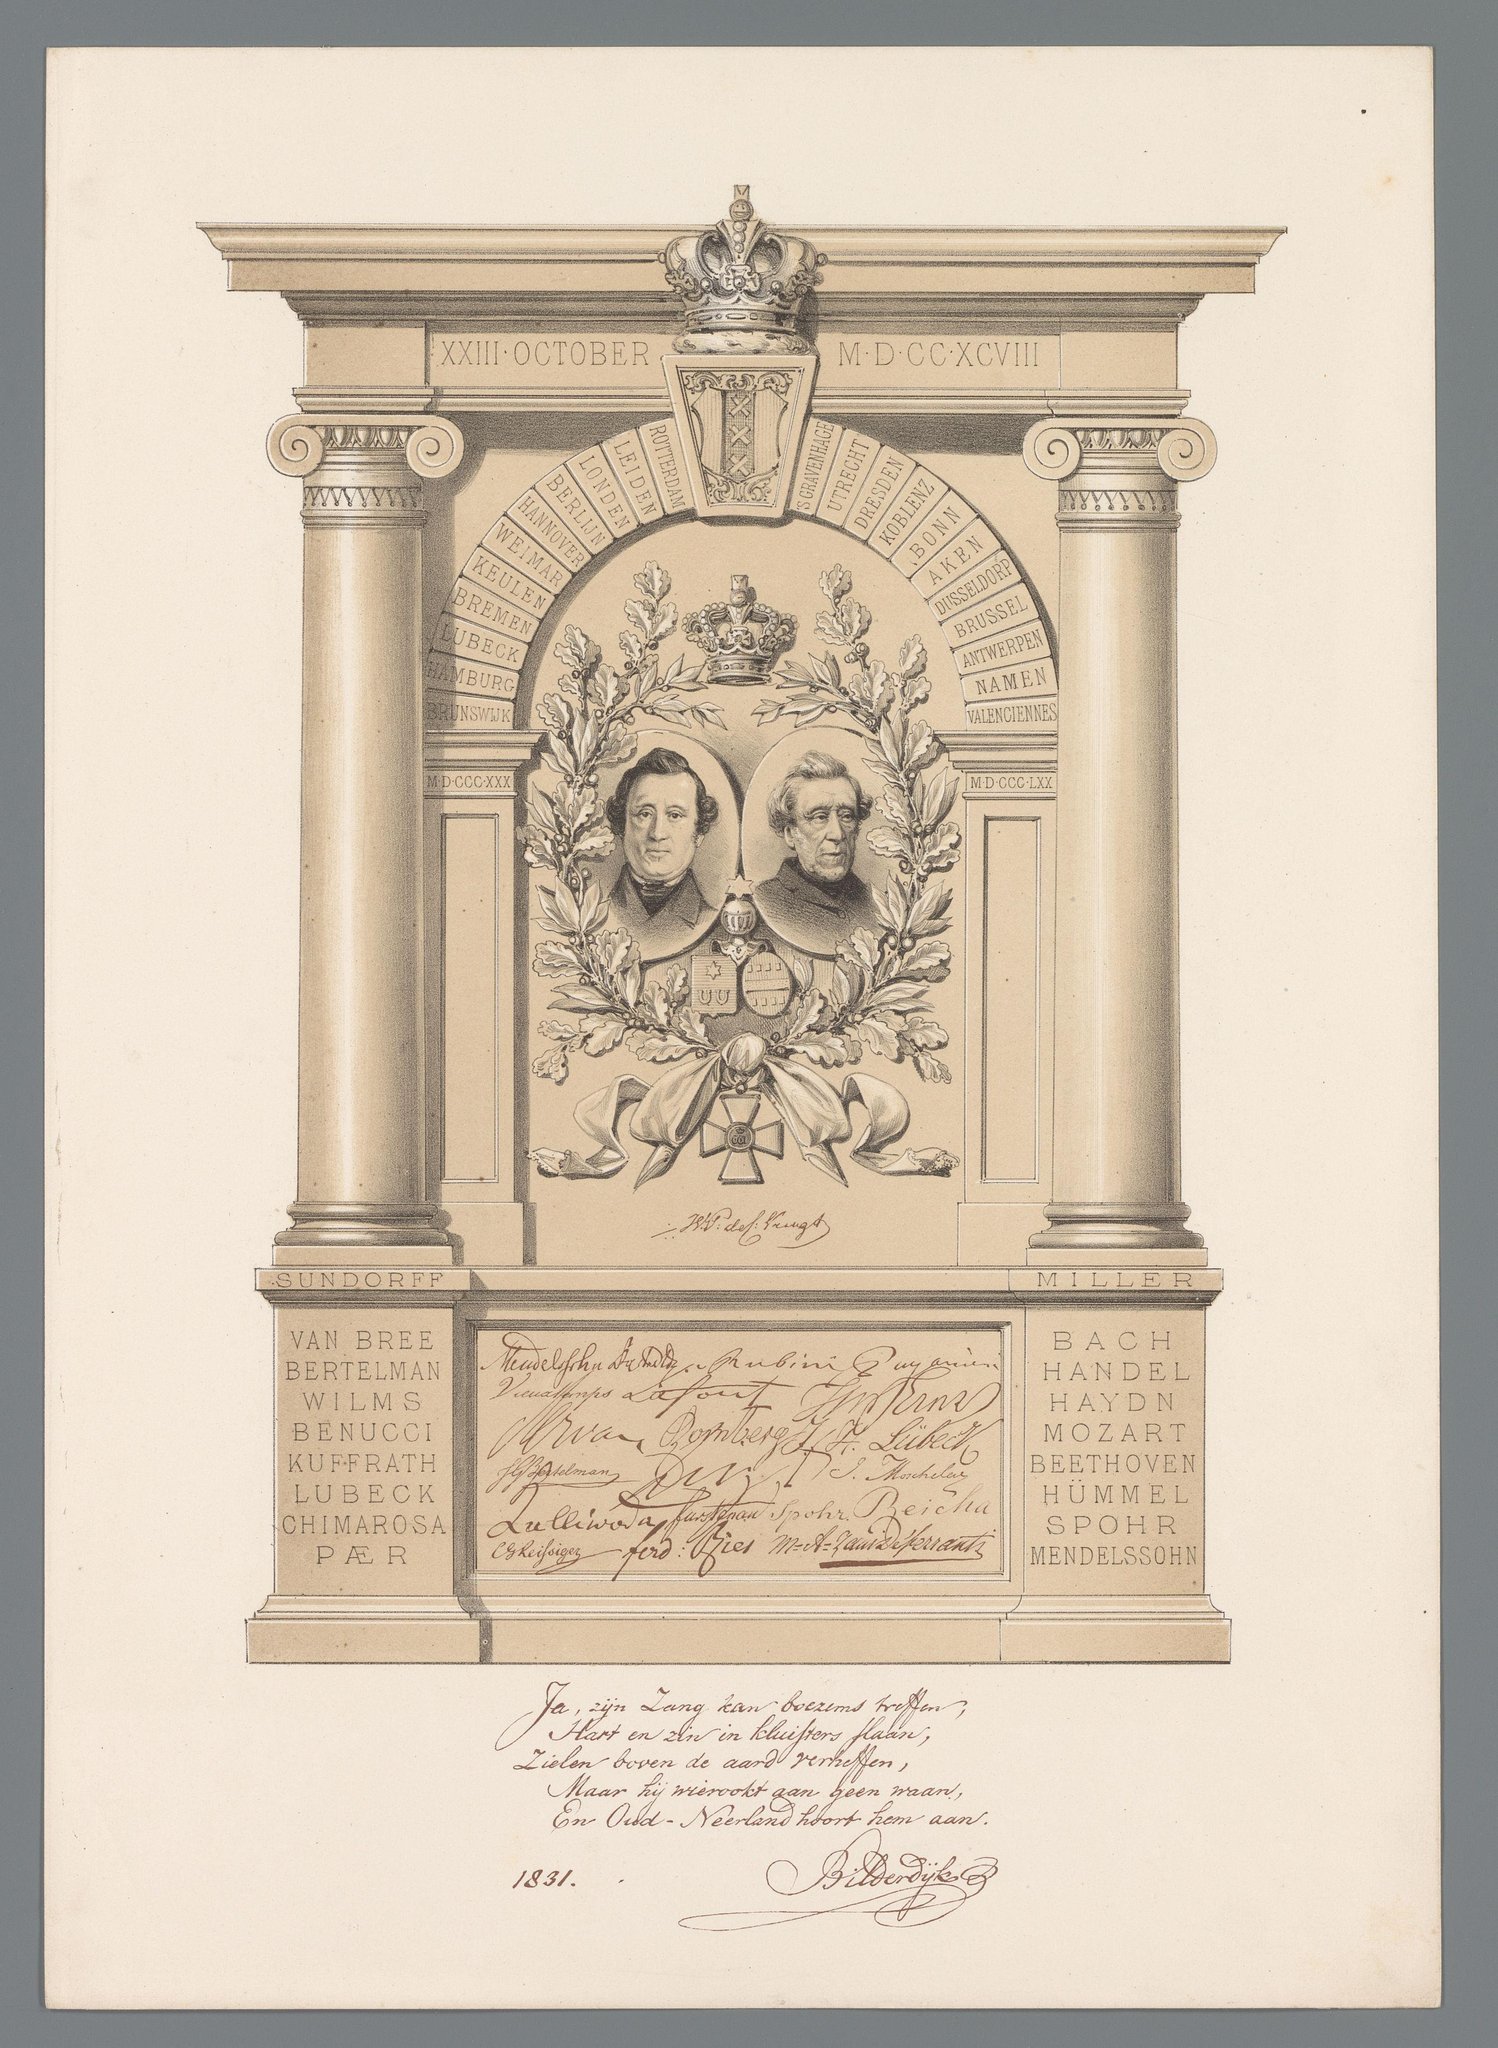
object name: print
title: Monument met twee portretten van Willem Pasques de Chavonnes Vrugt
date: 1872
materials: paper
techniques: tone lithography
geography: netherlands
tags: amsterdam, haarlem, willem pasques de chavonnes vrugt, honouring the artist with laurel wreath, coat of arms (as symbol of the state, etc.) (+ city; municipal), crown (symbol of sovereignty), historical persons, portrait of opera-singer, half-column, pilaster ~ architecture, armorial bearing, heraldry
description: Met facsimile in rood van zijn handtekening en twintig handtekeningen van andere musici uit zijn tijd, en een vierregelig vers van Bilderdijk. De portretten zijn gevat in medaillons, met direct rondom een lauwerkrans. Naast het linkerportret het jaartal 1830, naast het rechterportret het jaartal 1870. Boven de portretten een boog, bestaande uit stenen waarop verschillende steden staan, mogelijk steden waar de tenorzanger heeft opgetreden. De sluitsteen van de boog wordt gevormd door het stadswapen van Amsterdam, met daarbovenop een kroon. Aan weerszijden van de boog twee pilasters met Ionisch kapiteel. Onder de pilasters de namen van verscheidene componisten.